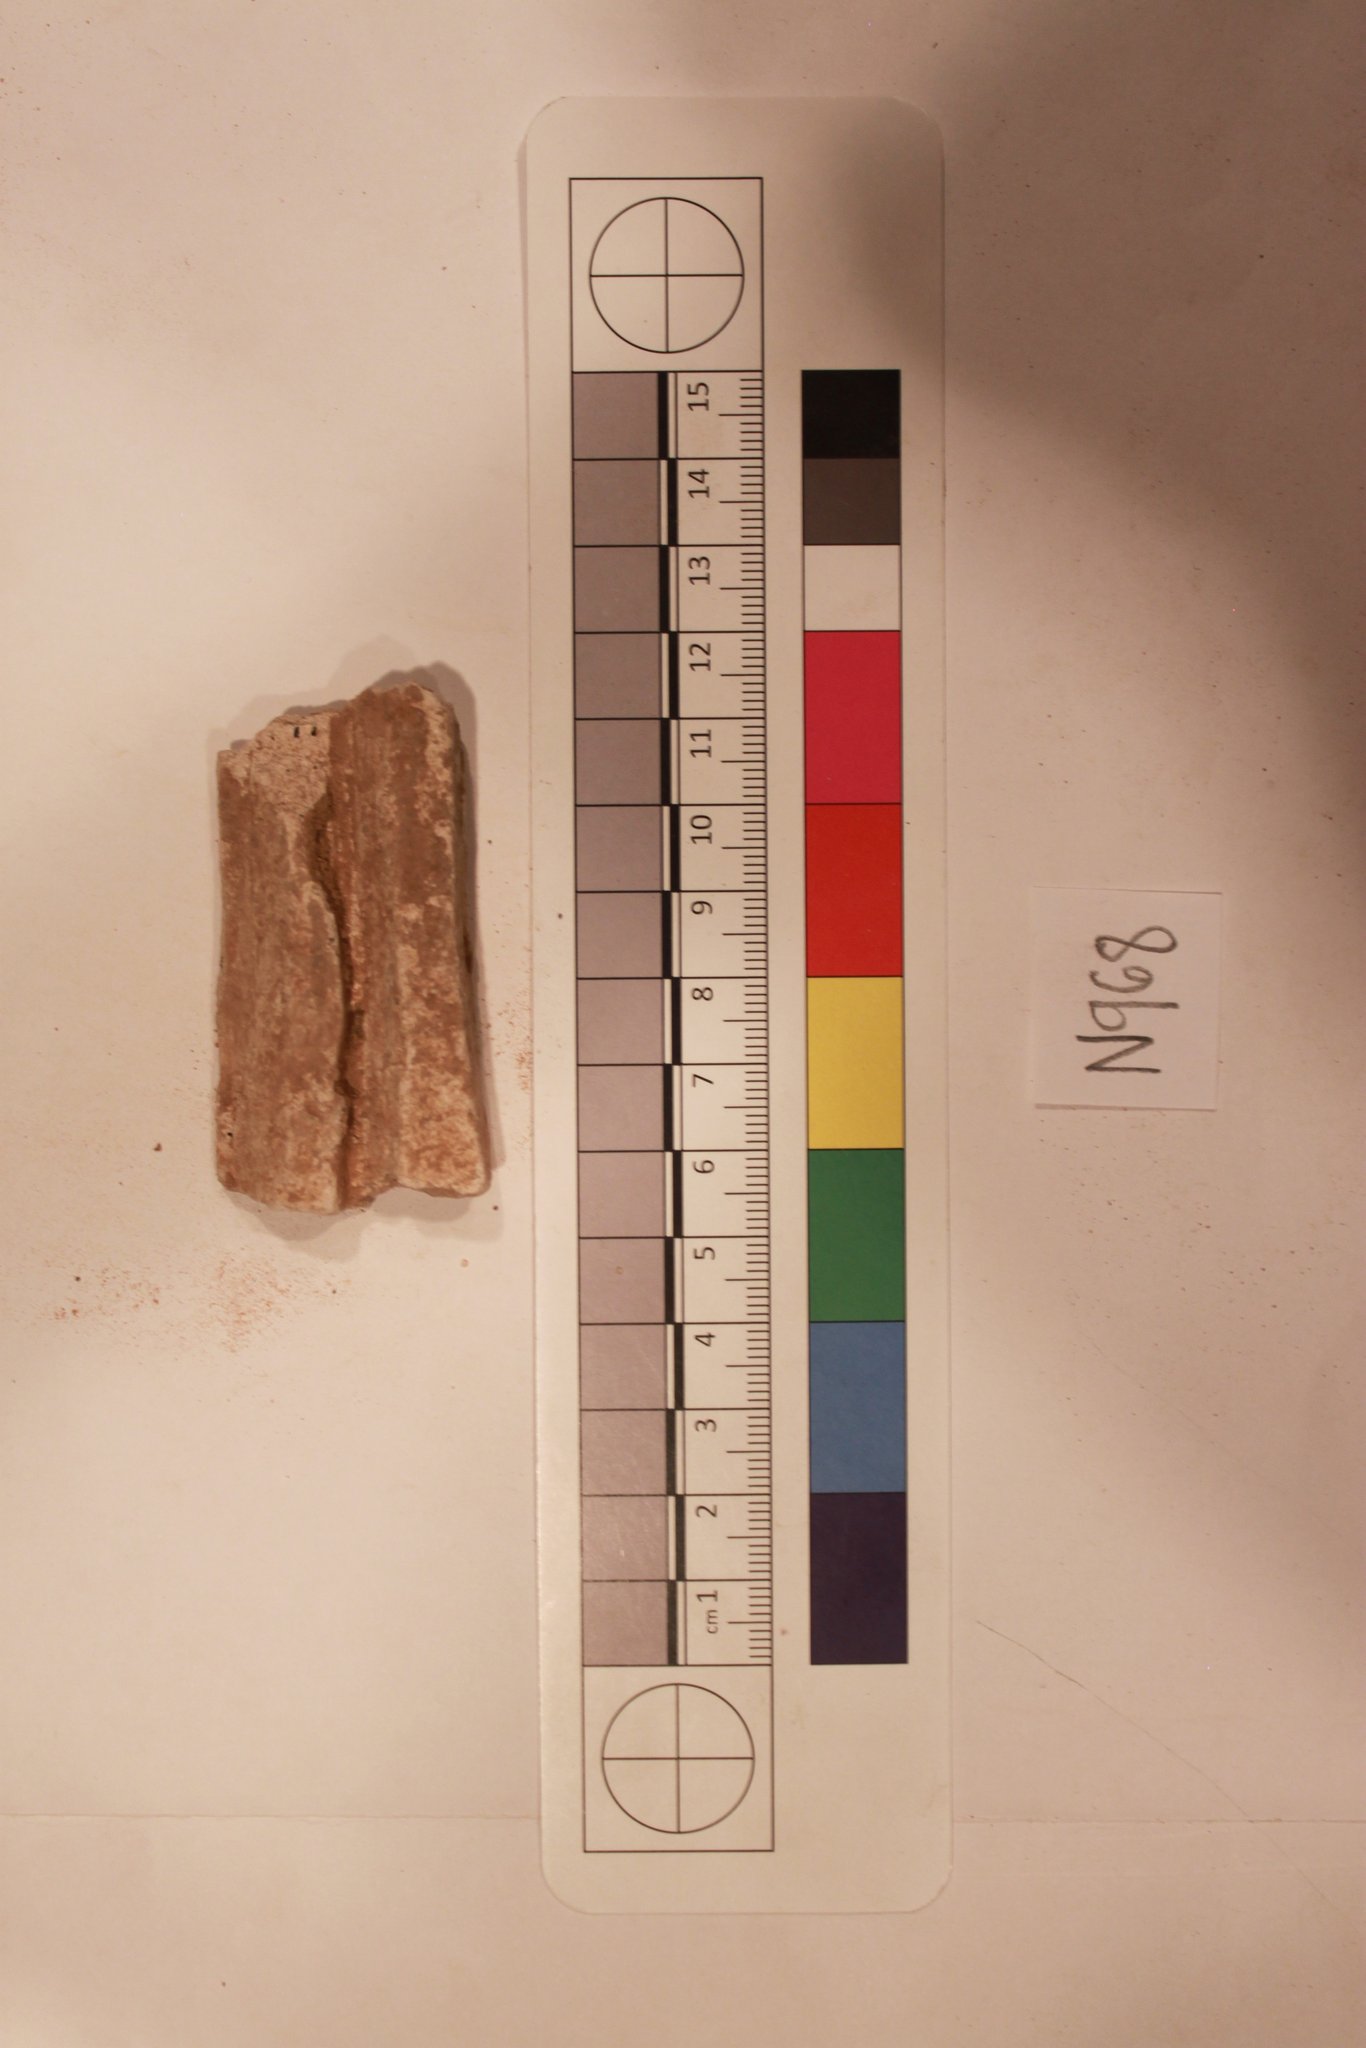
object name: fragment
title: Stucco Fragment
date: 701-1200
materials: plaster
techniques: carving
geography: iran